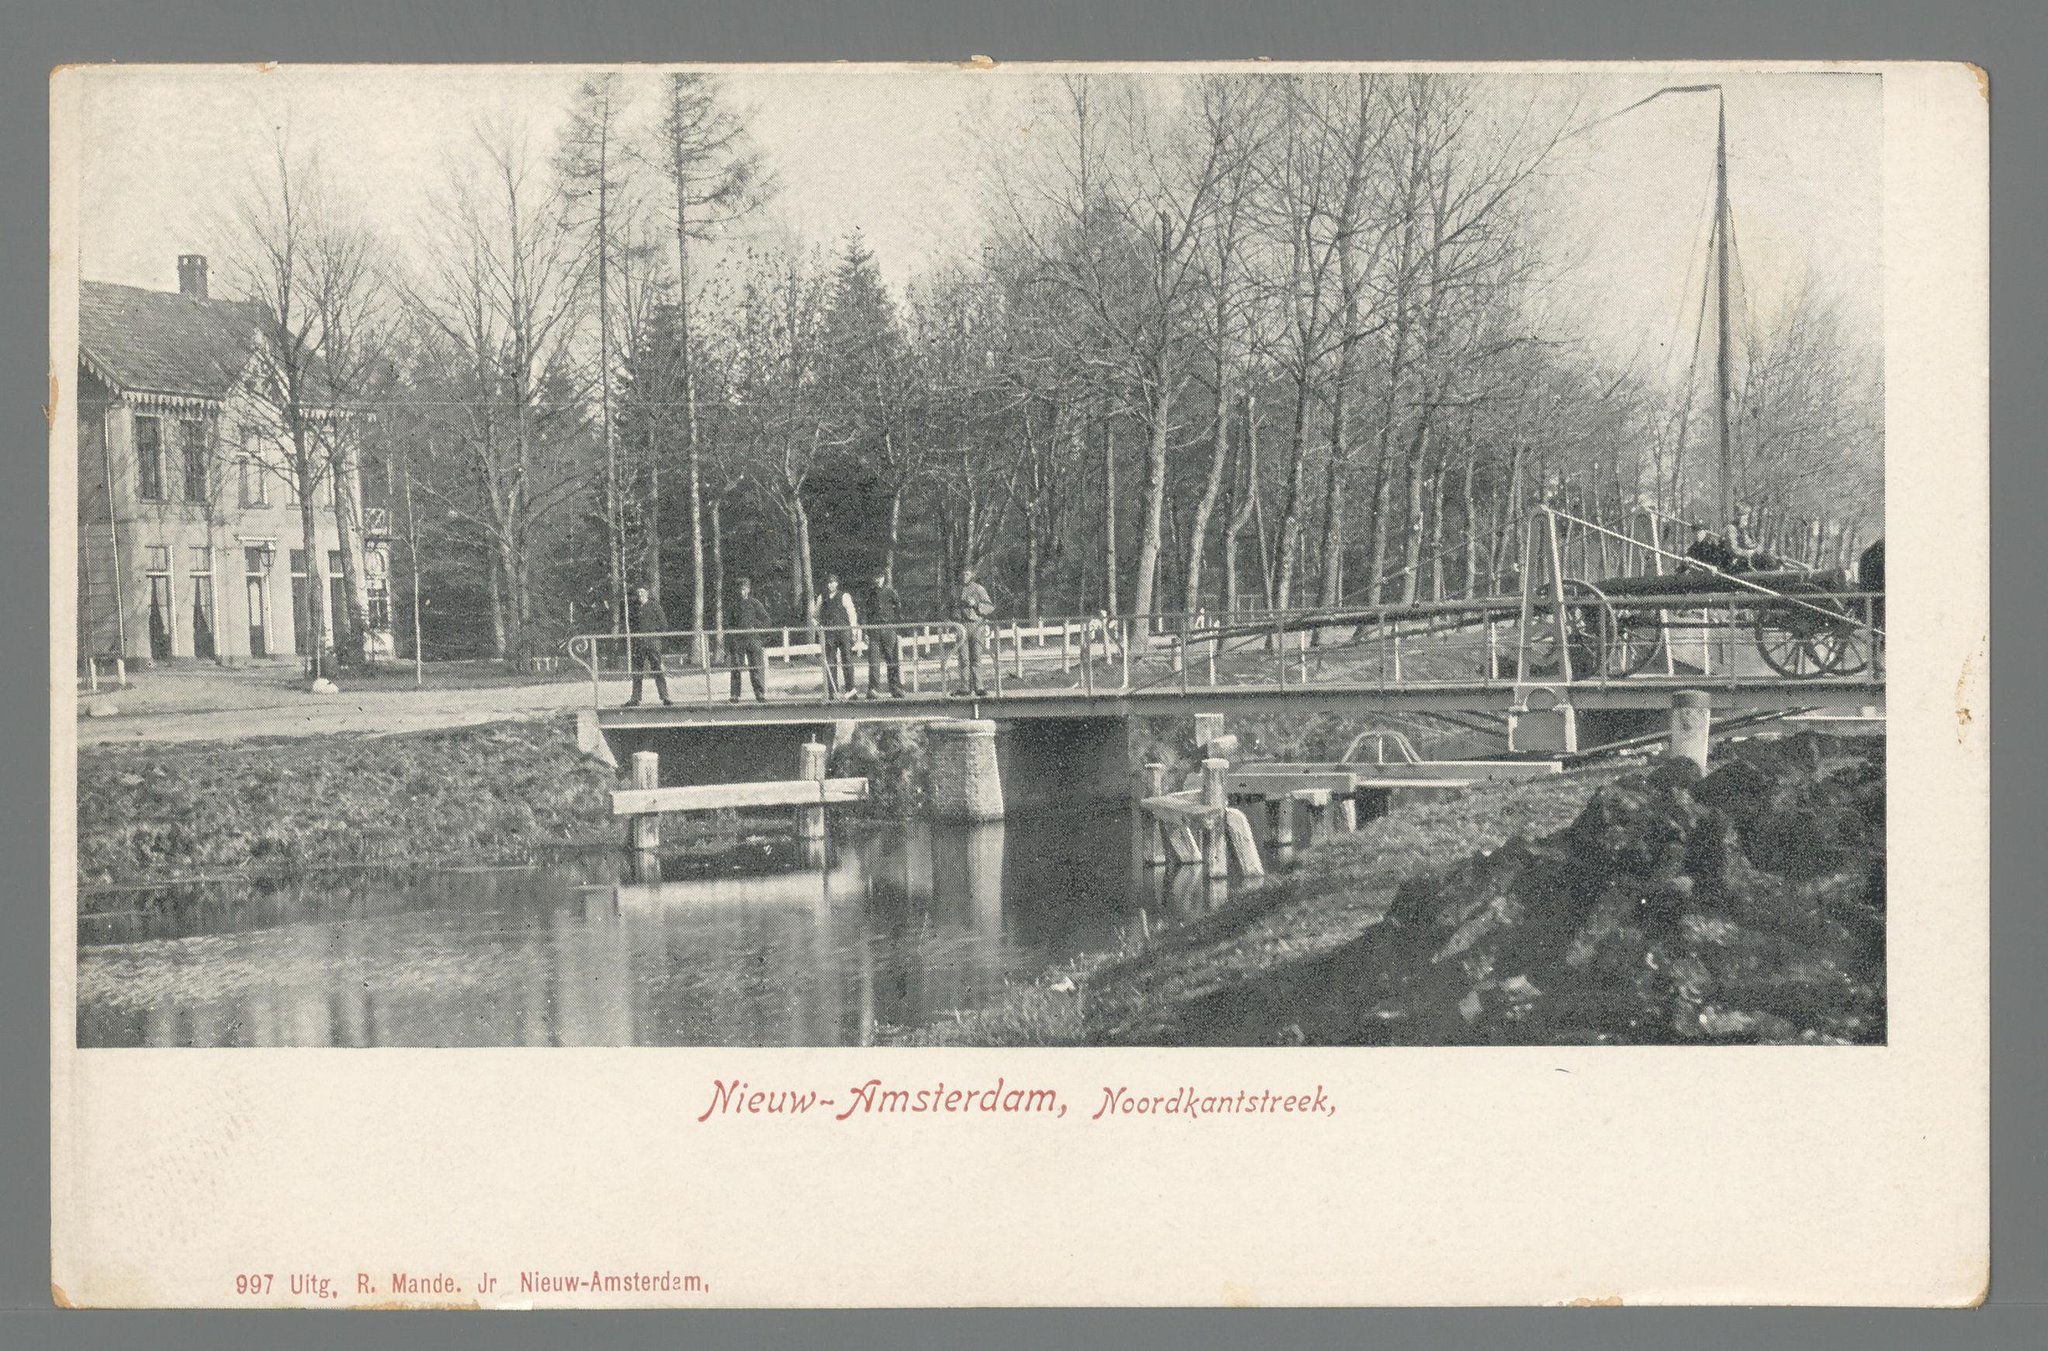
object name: photomechanical print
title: Nieuw-Amsterdam, Noordkantstreek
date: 1892-1905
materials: cardboard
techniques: autotype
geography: nieuw-amsterdam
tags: city-view, and landscape with man-made constructions, canals, waters (in village), bridge in village across river, canal, etc.